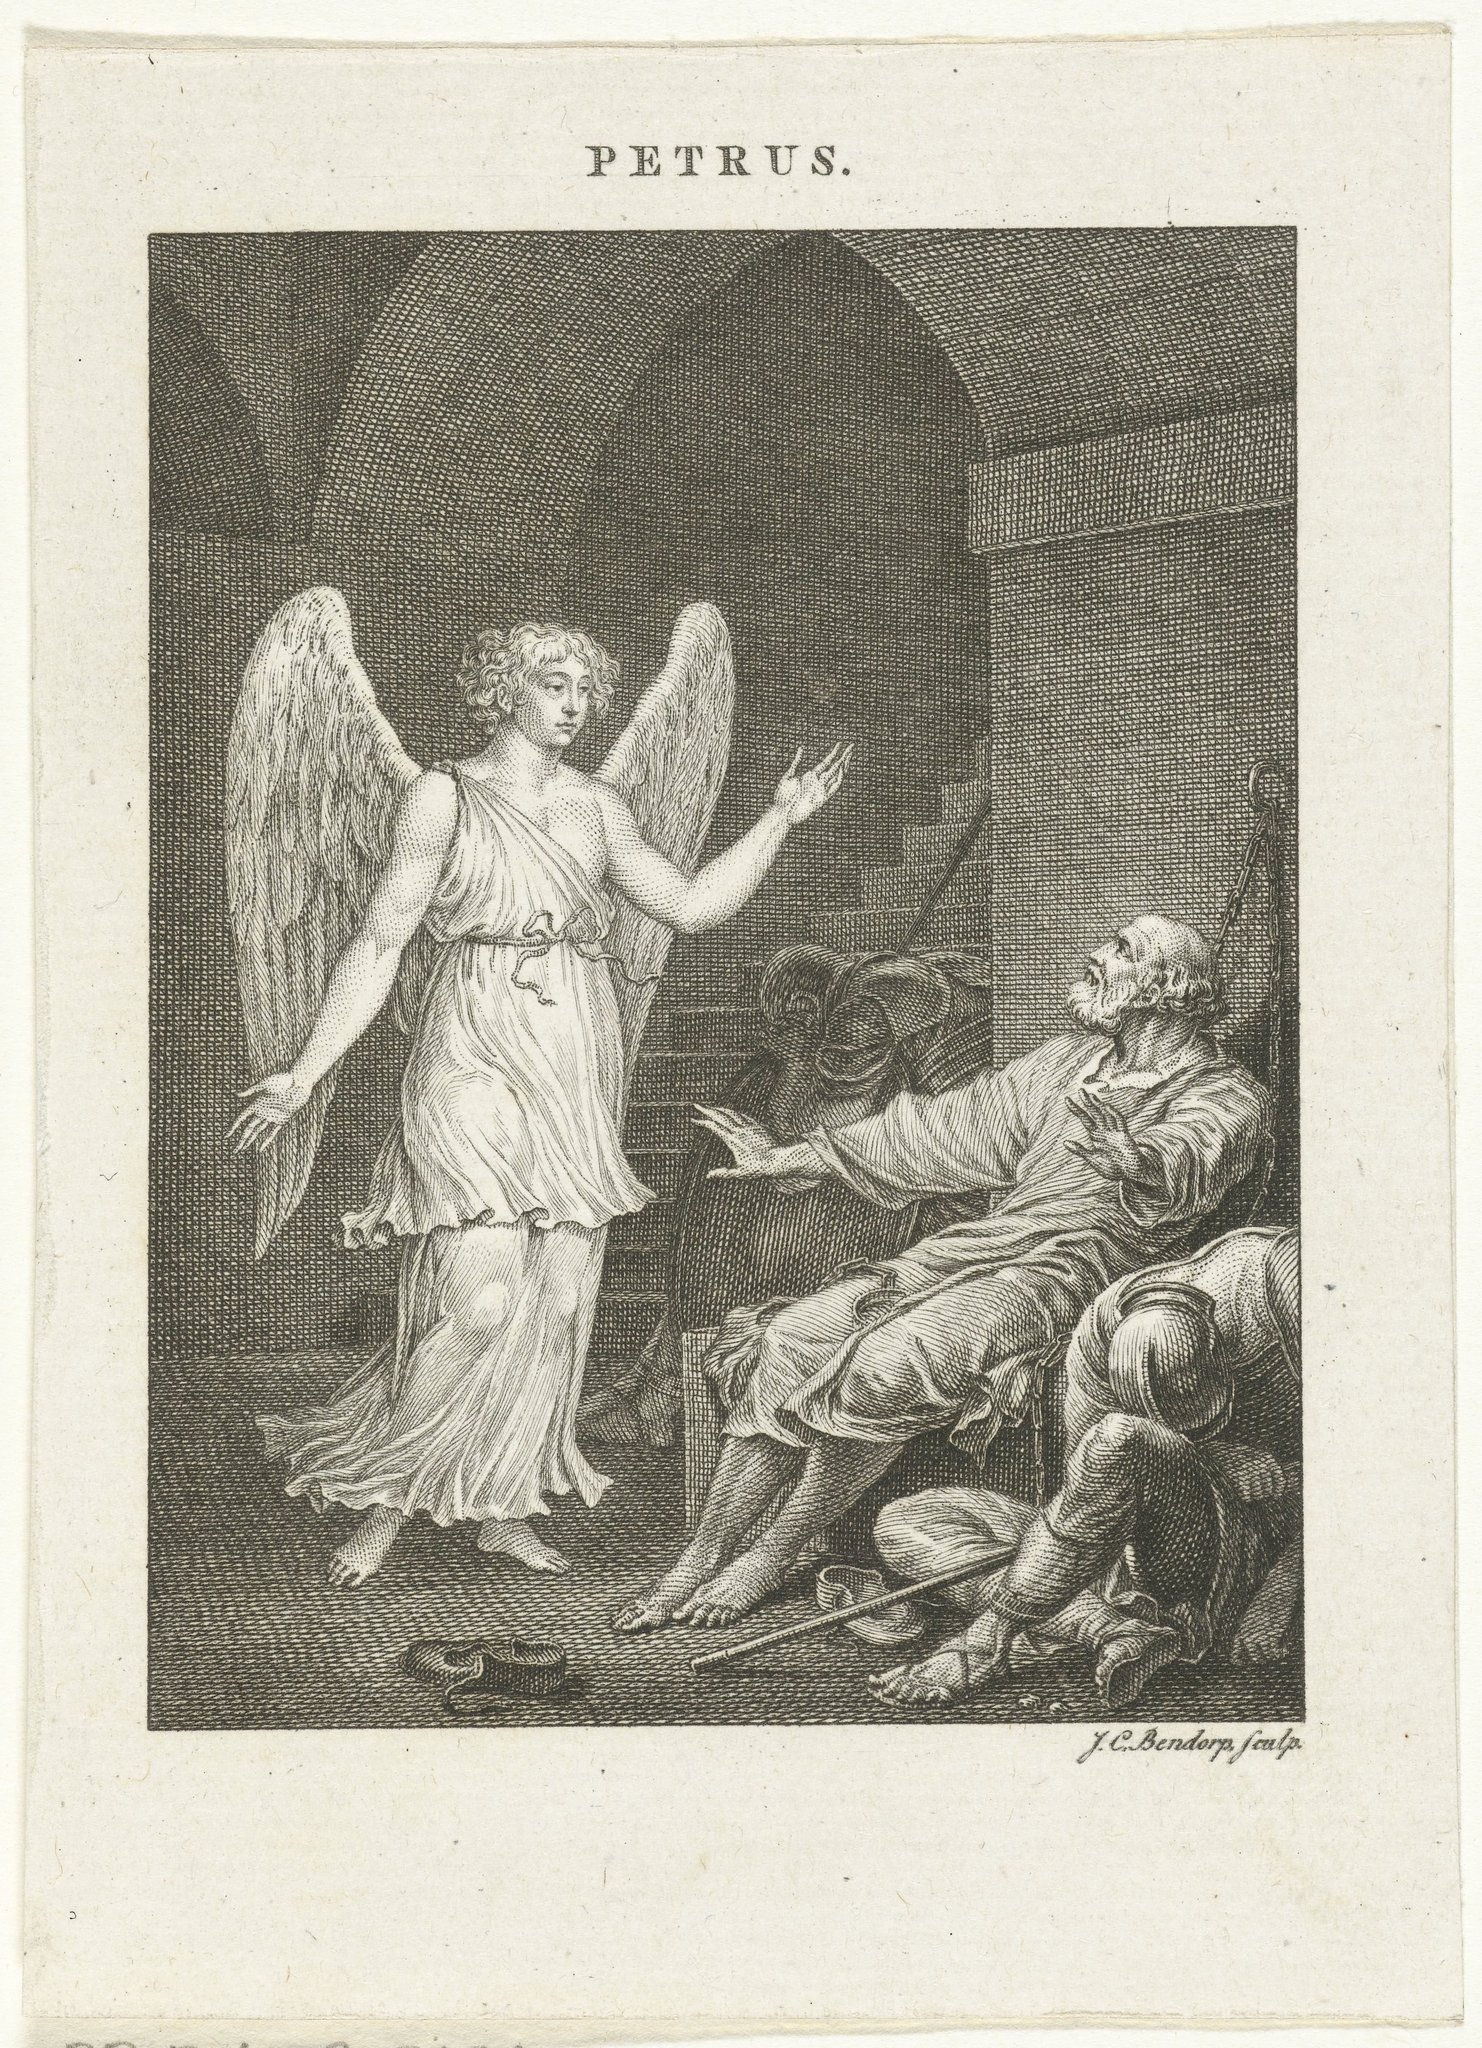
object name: book illustration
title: Engel opent deur van gevangenis voor heilige Petrus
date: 1776-1824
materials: paper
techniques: etching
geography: rotterdam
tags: at night an angel opens the door of the prison ~ life and acts of peter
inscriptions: collector's mark: Lugt 2228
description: Prent uit: Nederlandsche muzen-almanak, Johannes Immerzeel (uitgever), Rotterdam 1824.